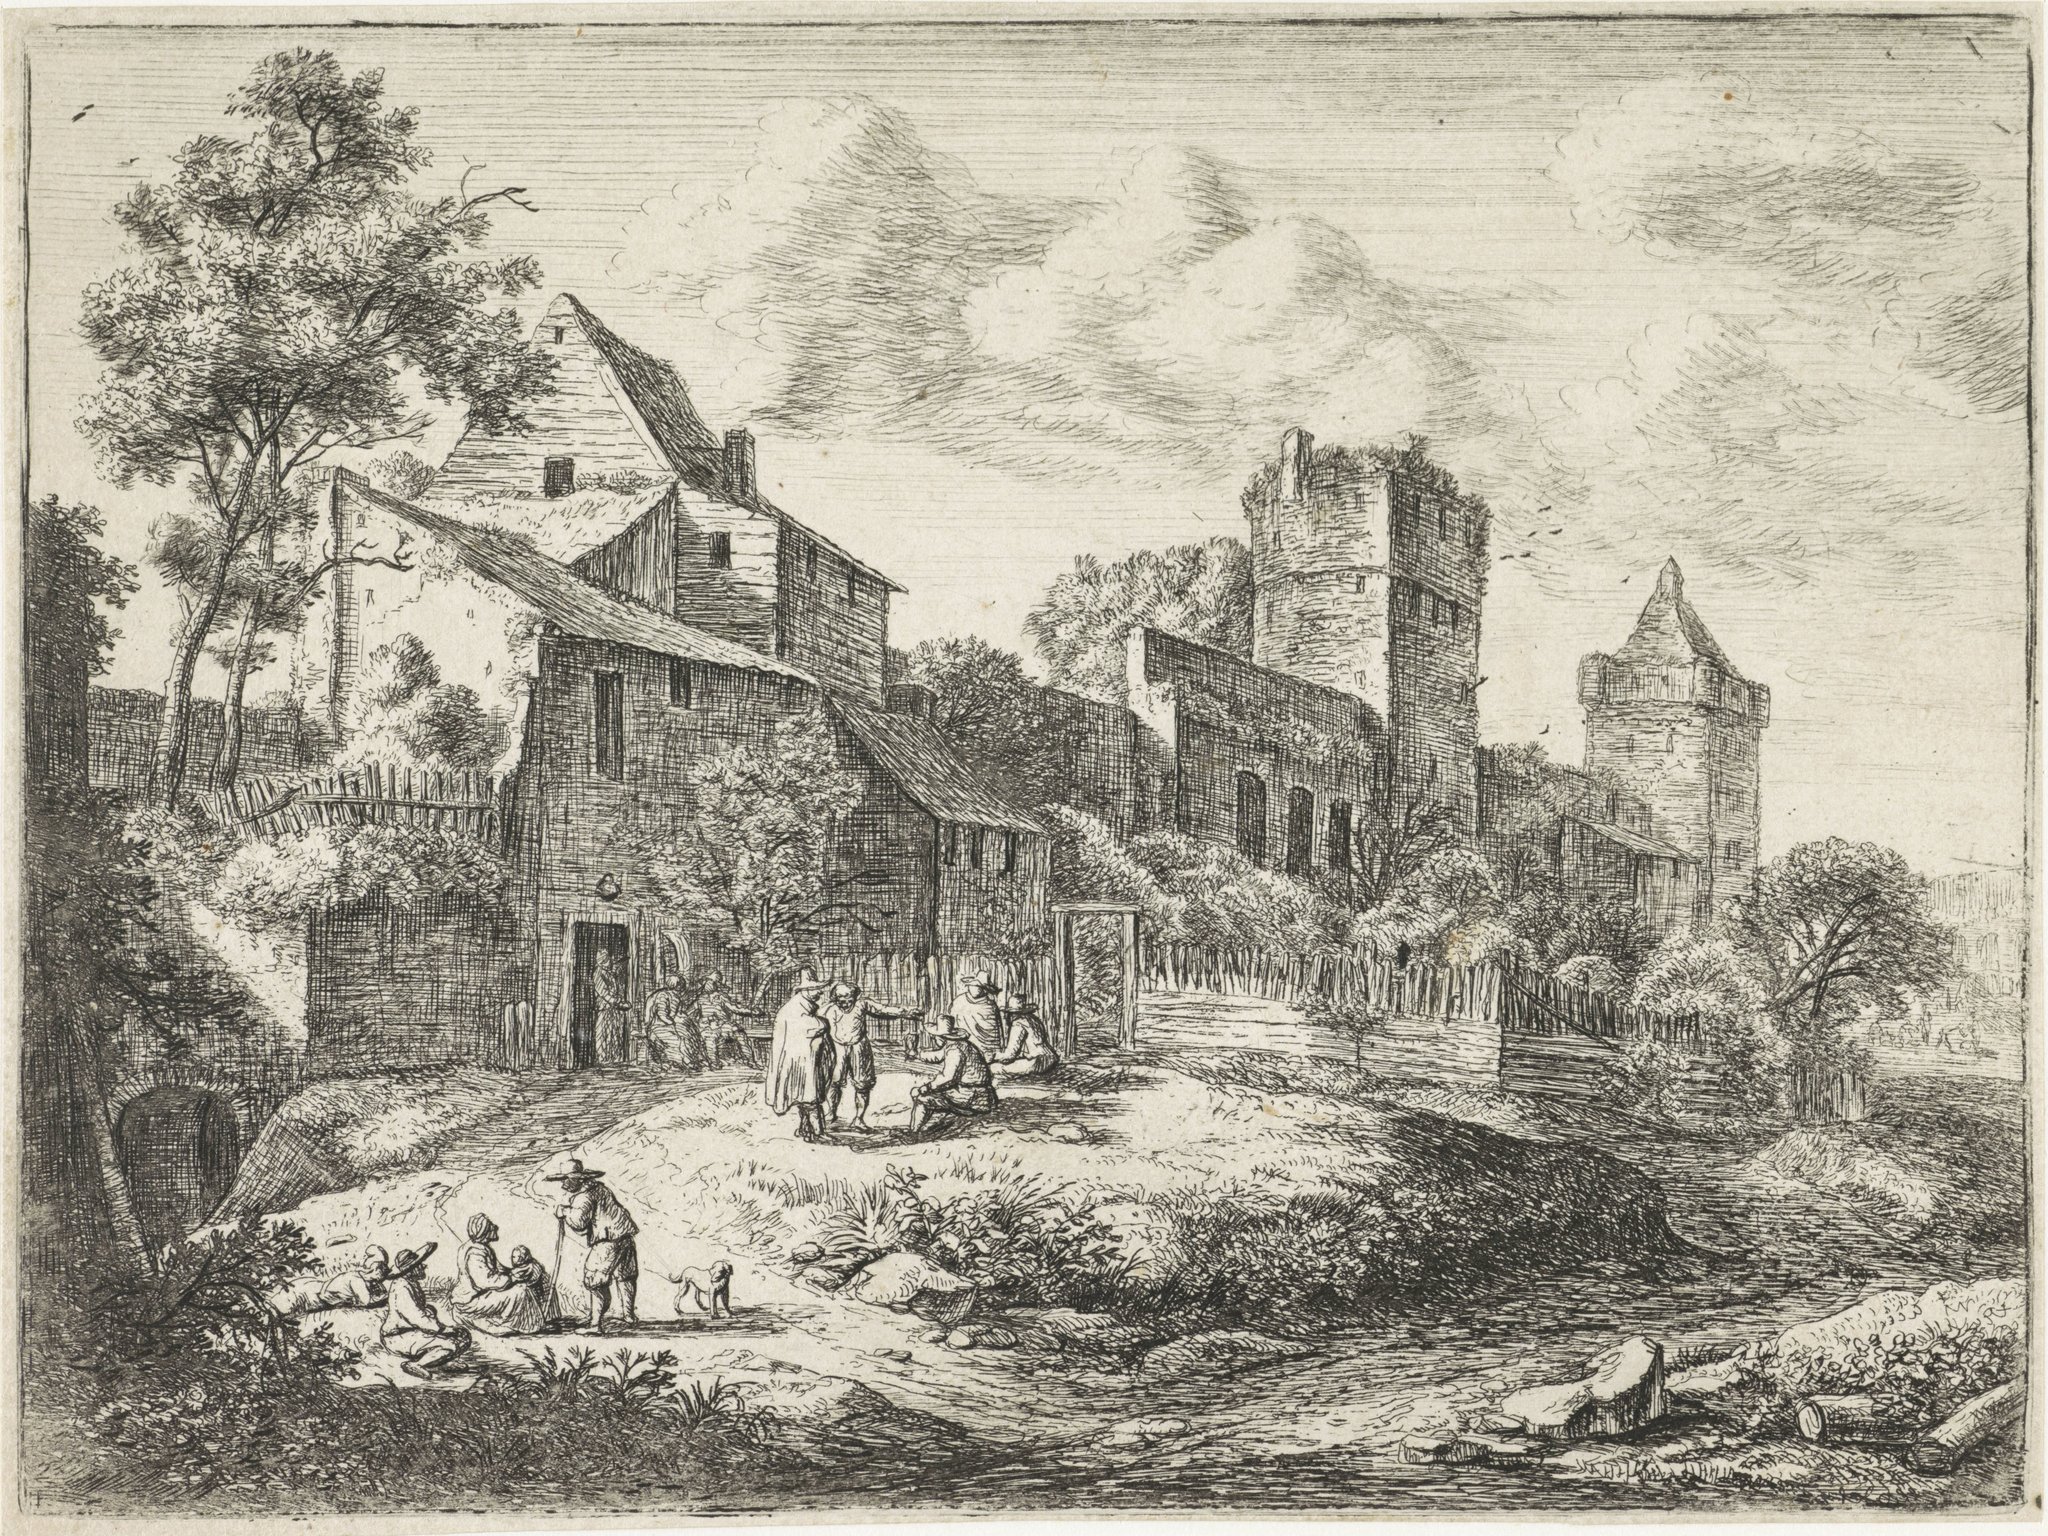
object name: print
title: Open plek voor een herberg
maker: anthonie waterloo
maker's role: draughtsman, painter, print maker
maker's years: 1609-1690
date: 1630-1663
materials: paper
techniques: etching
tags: towers ~ fortified city, inn, coffee-house, public house, etc., city-walls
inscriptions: collector's mark: Lugt 240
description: Links is een herberg als onderdeel van een stadsmuur te zien. Voor de herberg is een plein met enkele figuren weergegeven. Rechts loopt een pad parallel aan de stadsmuur.